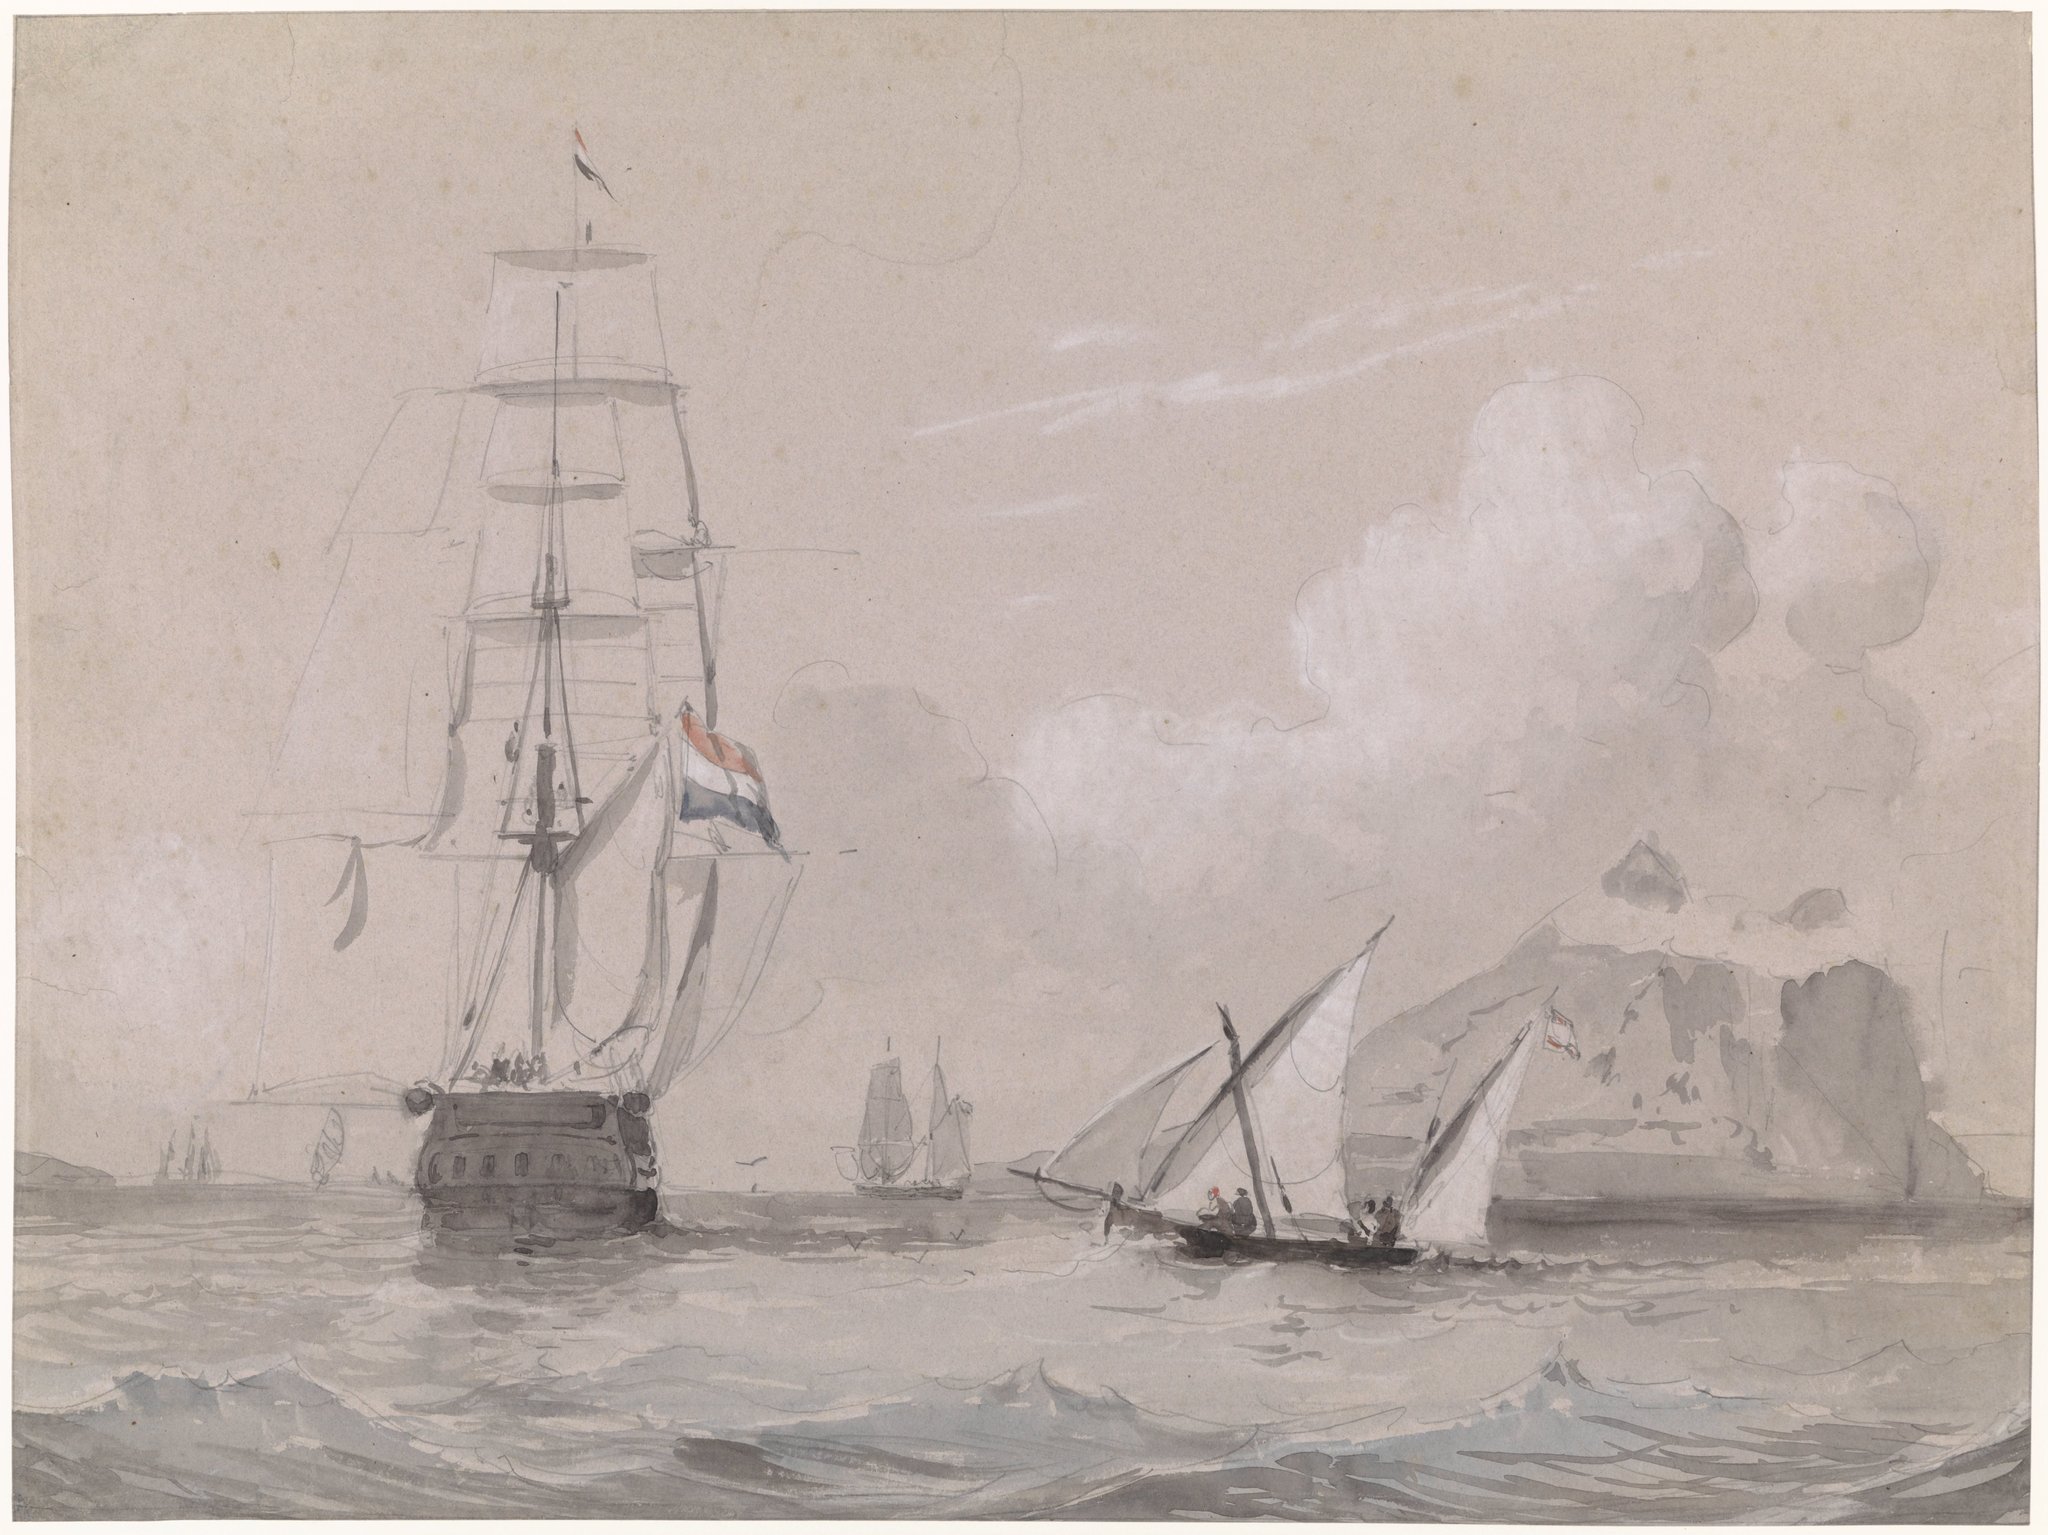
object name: drawing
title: Hollands zeilschip voor de kust van Gibraltar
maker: willem anthonie van deventer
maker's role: draughtsman, painter, print maker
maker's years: 1824-1893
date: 1834-1893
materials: paper, pencil, watercolor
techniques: brush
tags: rocky coast